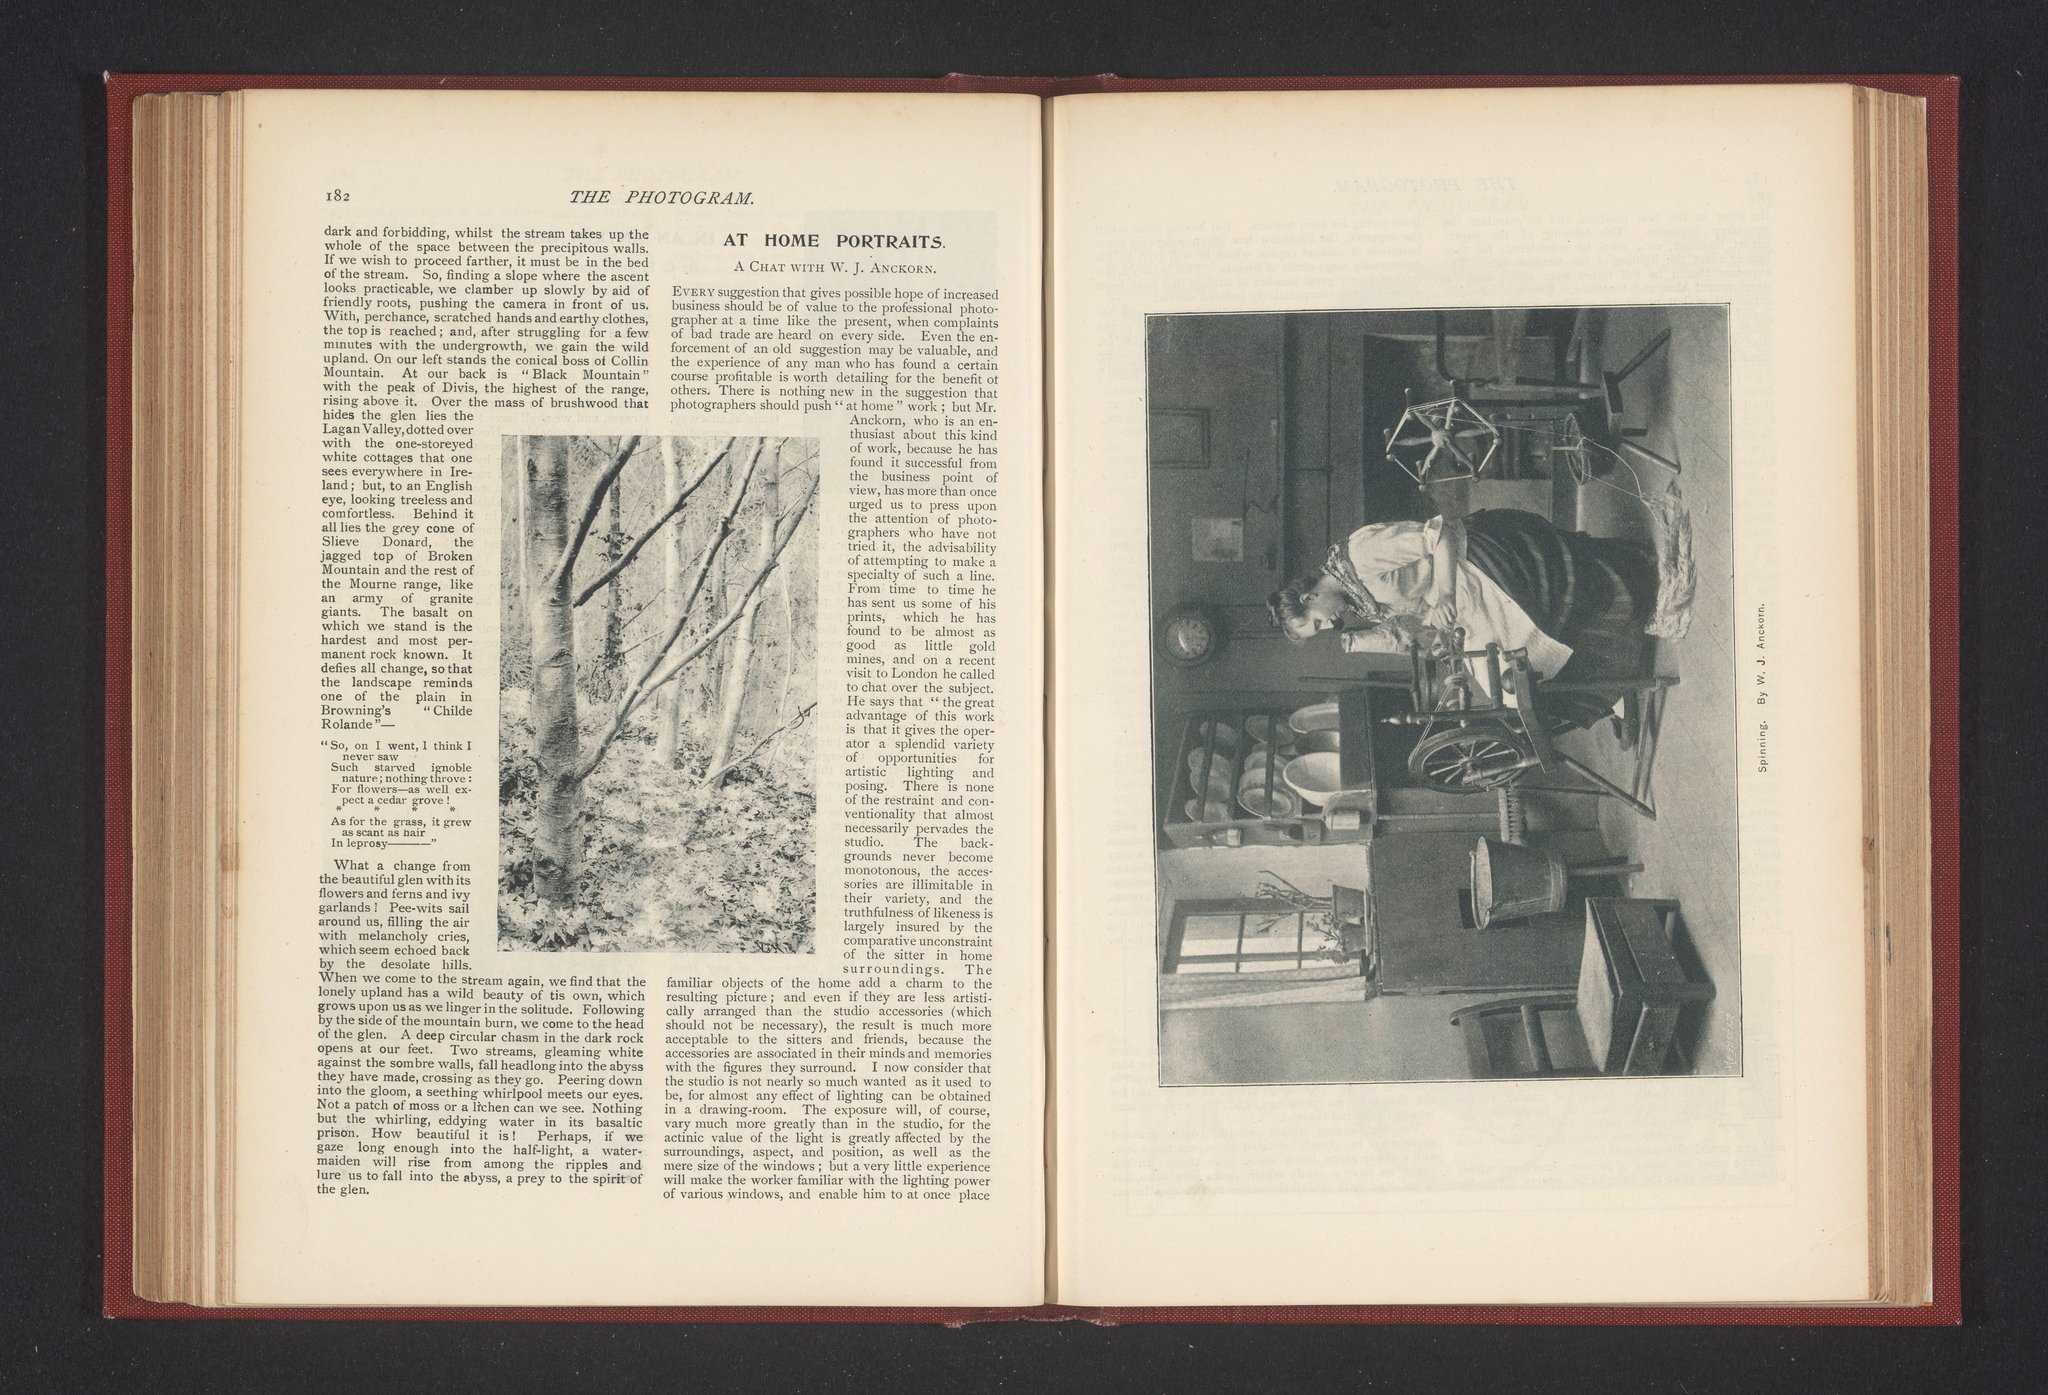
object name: photomechanical print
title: Vrouw bij spinnewiel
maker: john william anckorn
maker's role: fotograaf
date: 1889-1894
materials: paper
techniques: autotype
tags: spinning-wheel